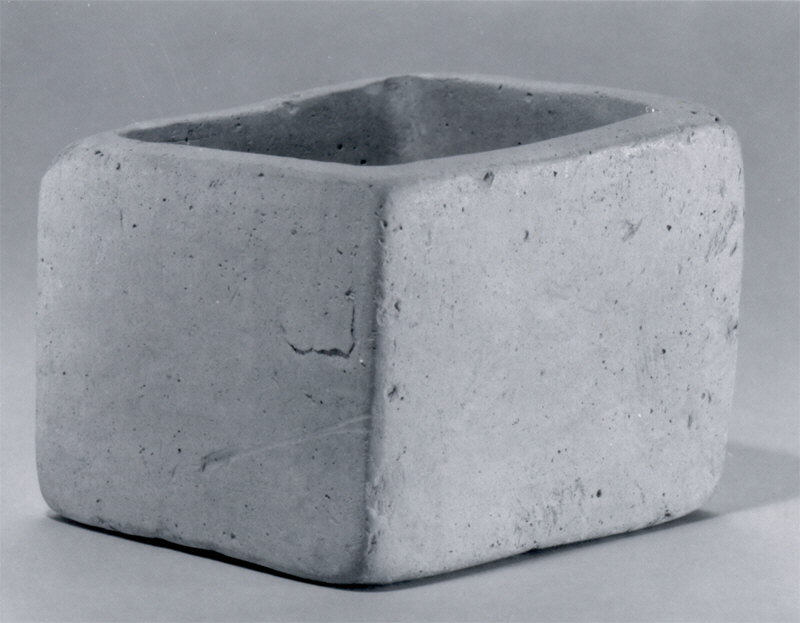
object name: box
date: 2000-1001 BCE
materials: faience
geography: central asia